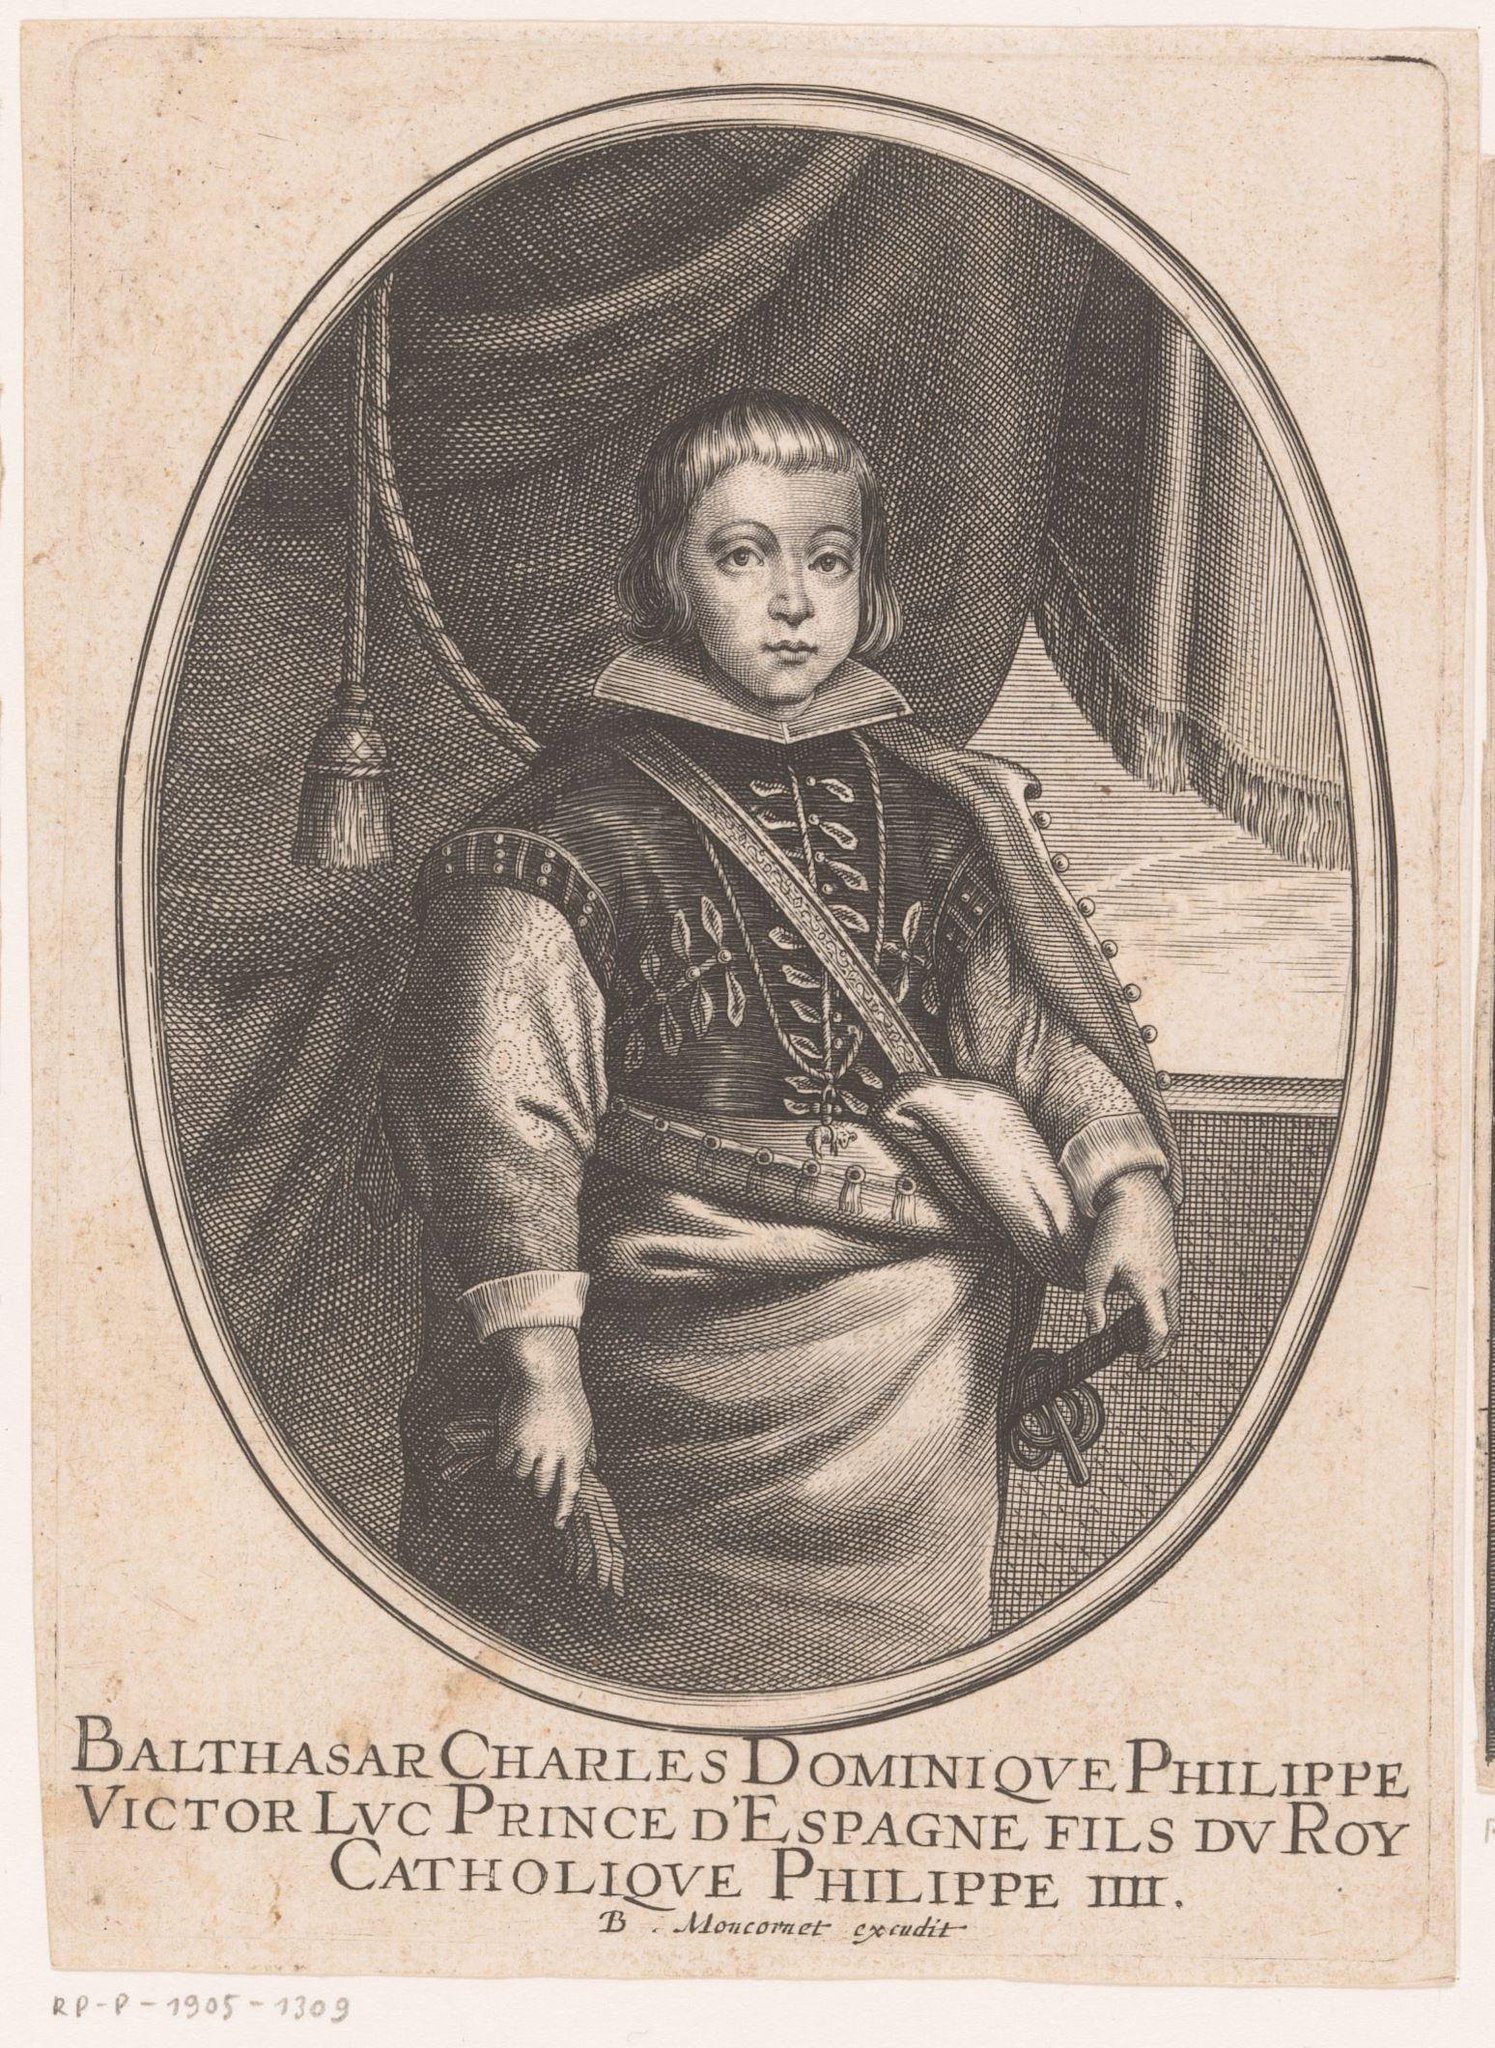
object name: print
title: Portret van Balthasar Karel van Spanje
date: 1610-1668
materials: paper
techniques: engraving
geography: paris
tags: historical persons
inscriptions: collector's mark: Lugt 2228